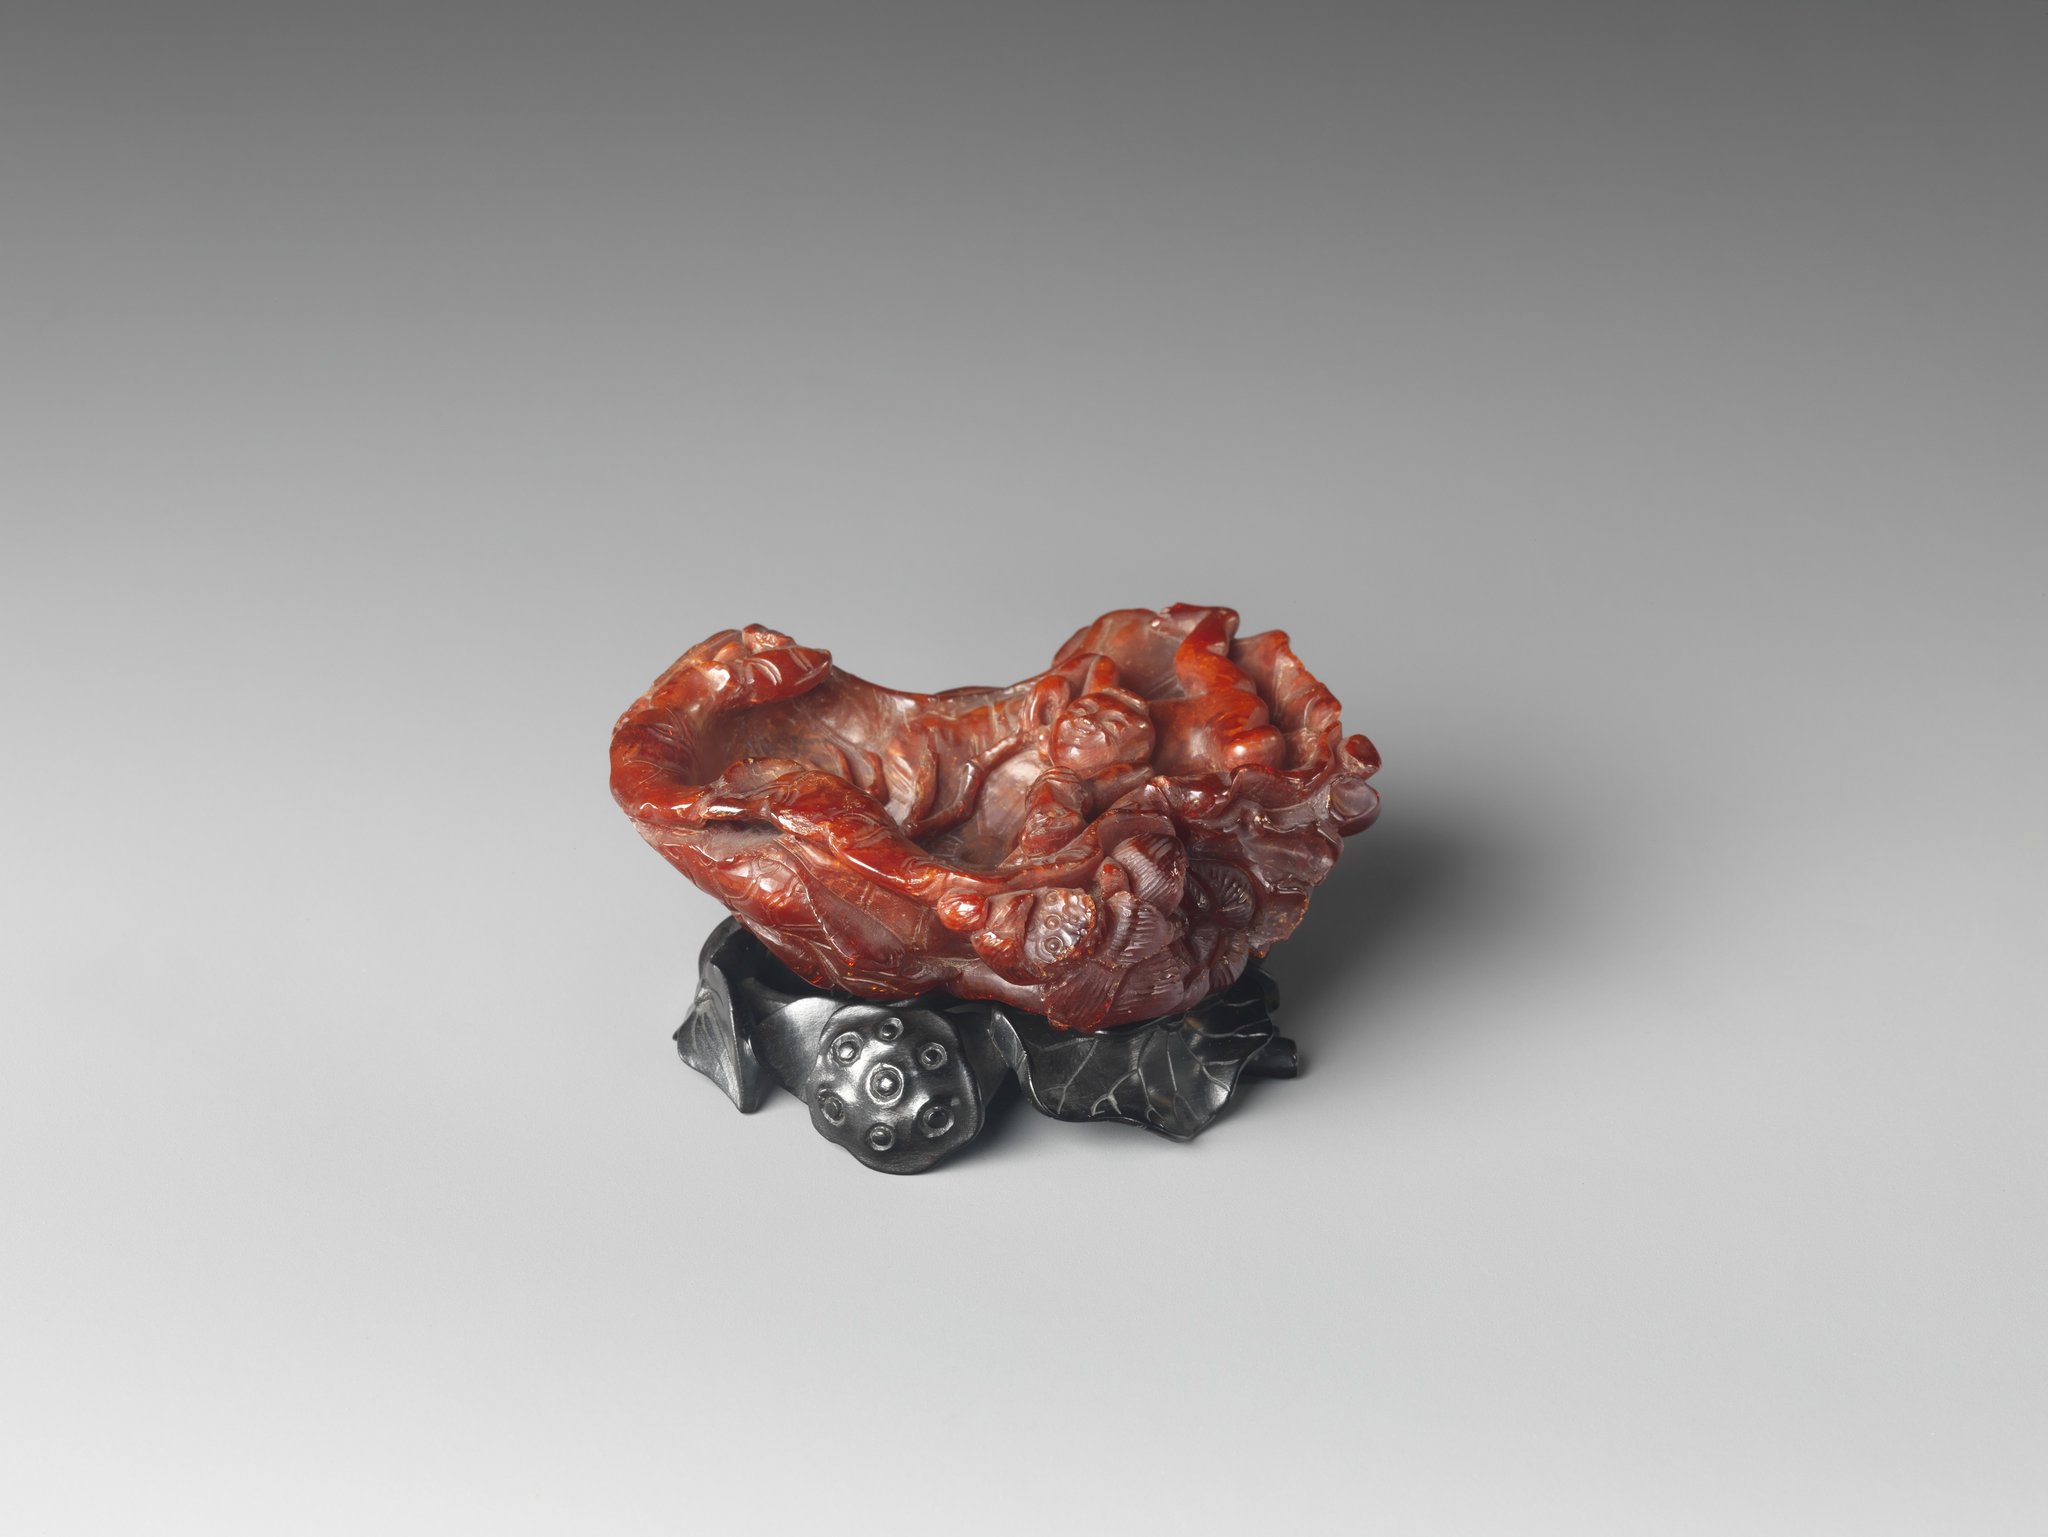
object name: dish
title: Dish with a Child Chasing a Fish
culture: chinese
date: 1701-1900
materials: amber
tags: children